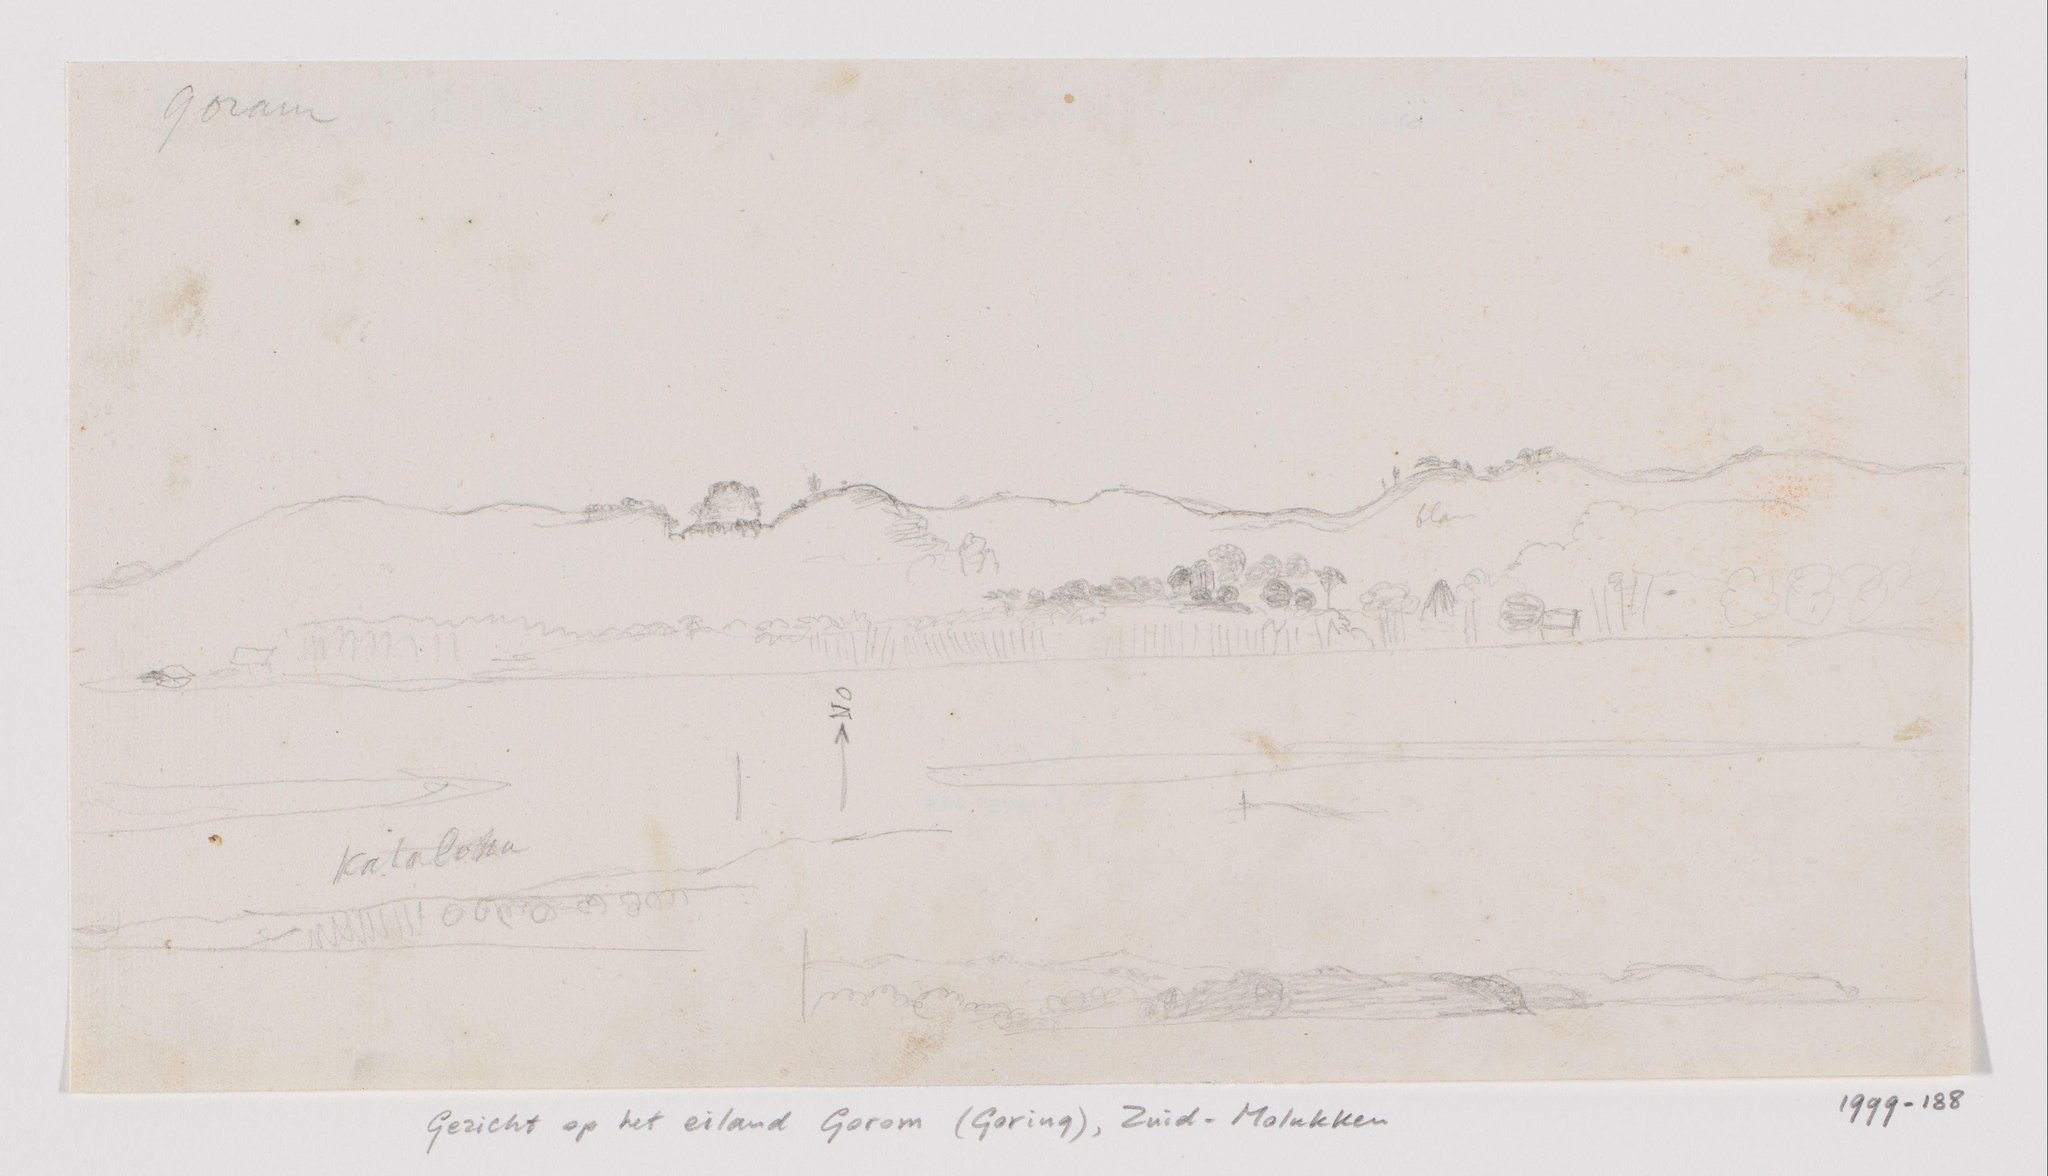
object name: drawing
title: Gezicht op het eiland Gorom (of Gorong), Centraal-Molukken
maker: adrianus johannes bik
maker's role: draughtsman, print maker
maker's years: 1790-1872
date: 1824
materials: paper, pencil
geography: south moluccas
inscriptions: annotation: ‘kleuraanduiding en "Goram, Katalotta"’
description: artikel over deze collectie in Bulletin van het Rijksmuseum 49 [2001], nr. 4, pp.343 e.v.